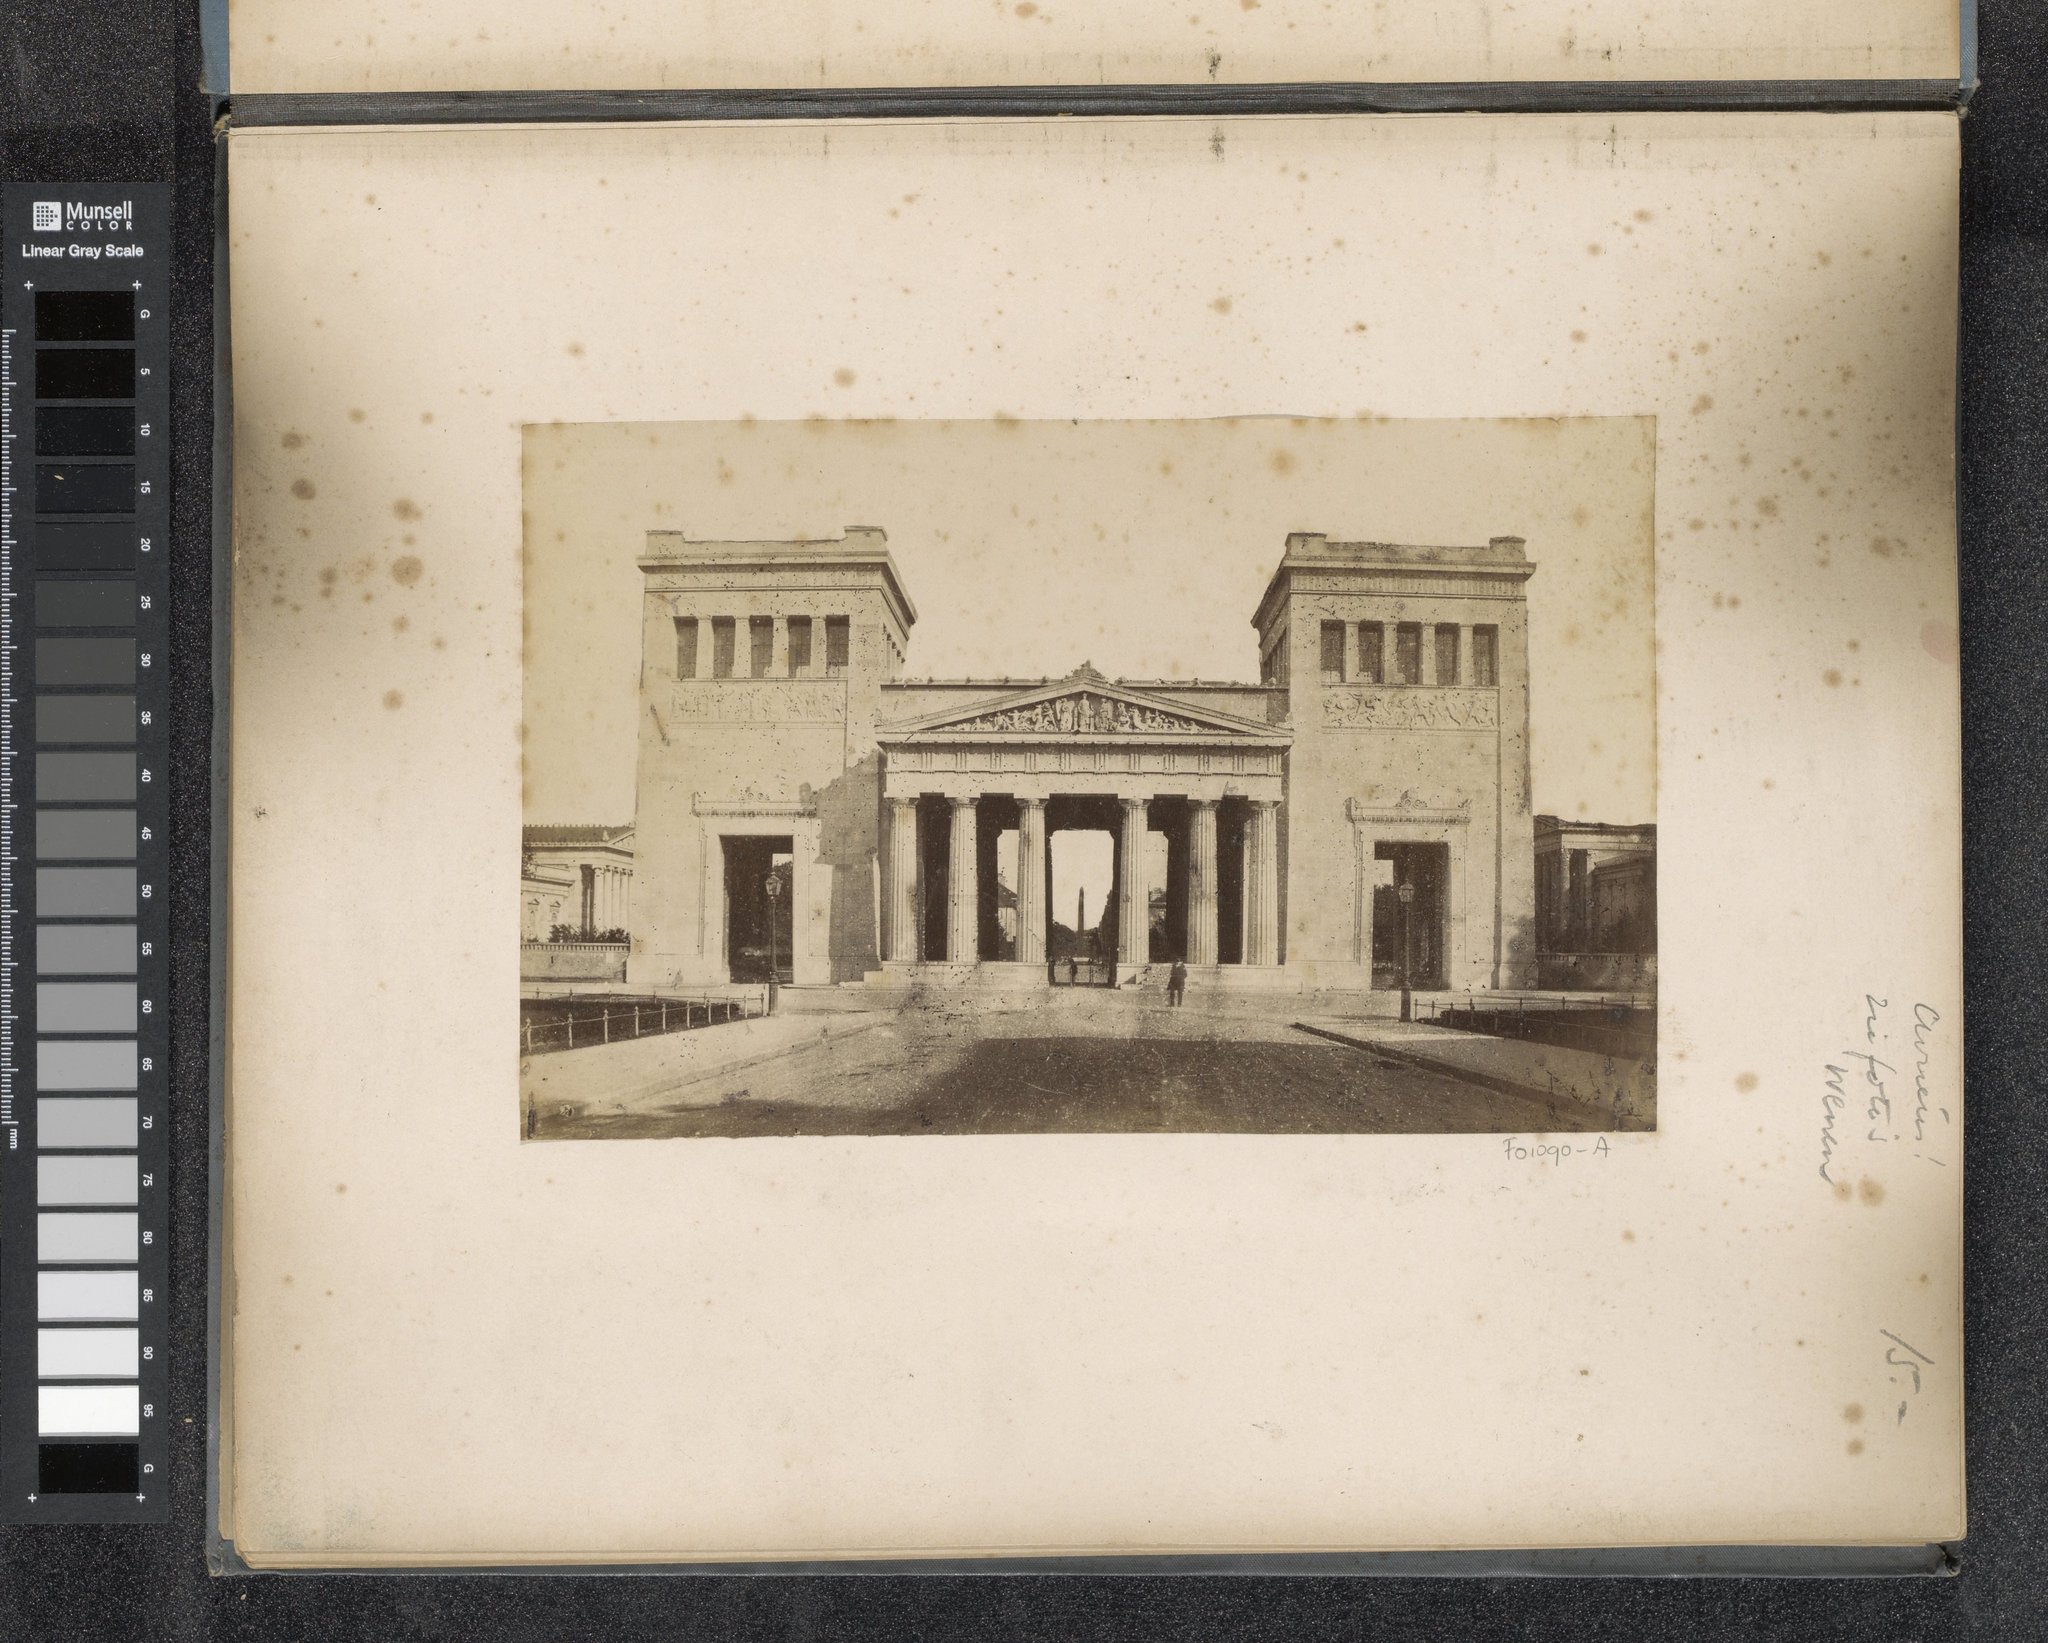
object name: photograph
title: Exterieur van het Propylaeon in München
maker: Anonymous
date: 1870-1900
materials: paper, photographic support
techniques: albumen print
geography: munich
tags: city-gate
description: Onderdeel van Reisalbum met foto's van bezienswaardigheden in Duitsland en Oostenrijk en van kunstwerken.